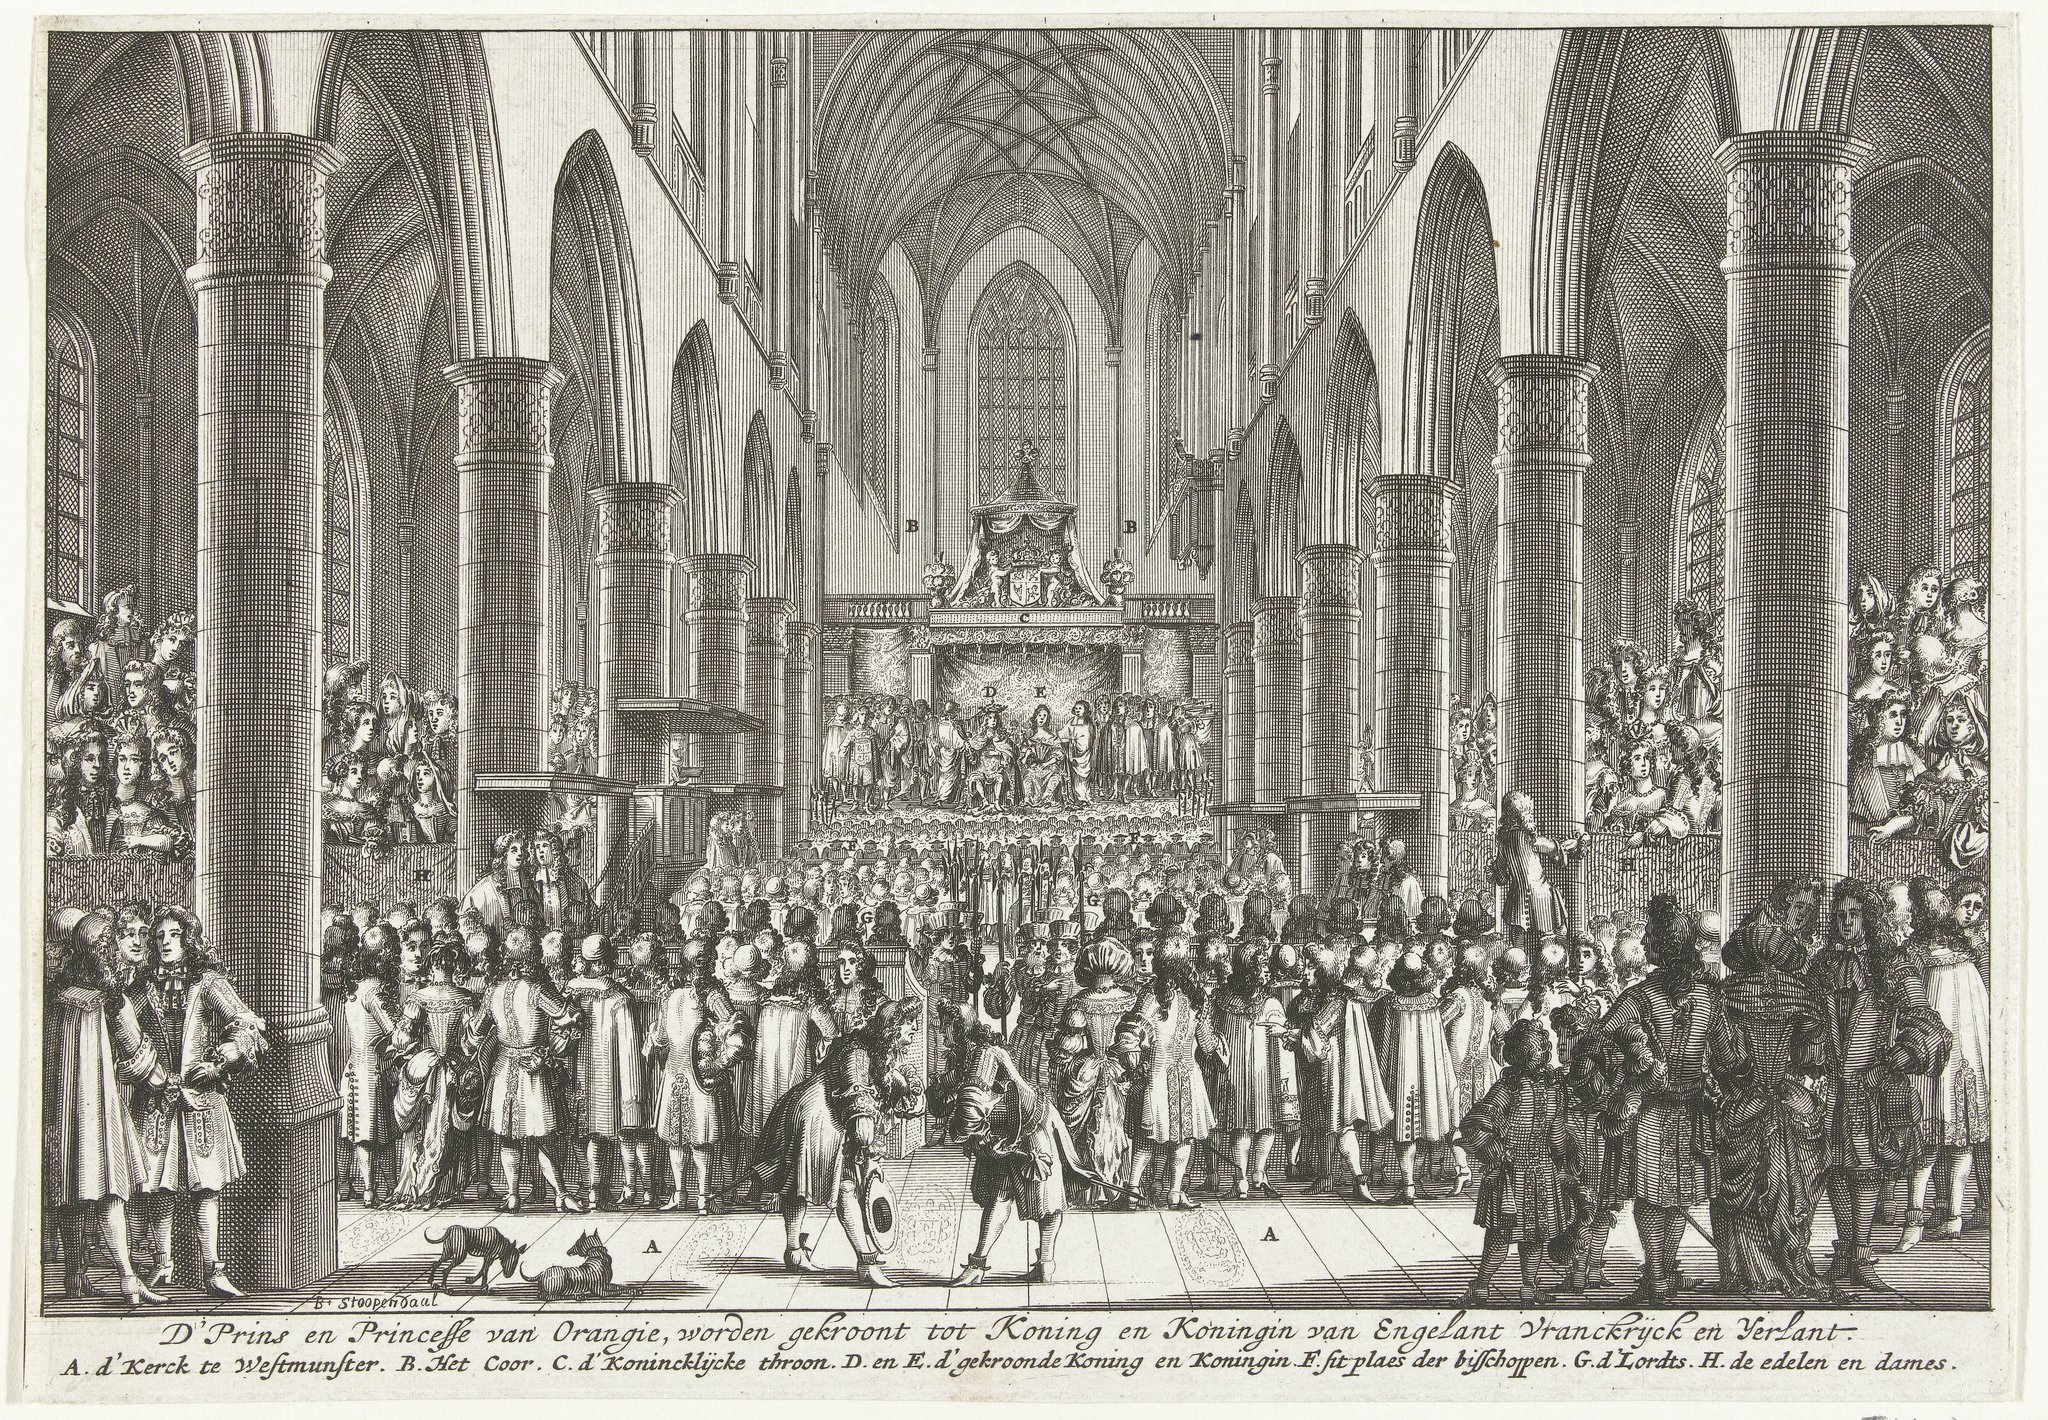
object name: print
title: D' Prins en Princesse van Orangie, worden gekroont tot Koning en Koningin van Engelant, Vranckrijck en Yerlant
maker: bastiaen stopendael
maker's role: print maker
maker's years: 1636-1693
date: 1689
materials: paper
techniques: engraving, etching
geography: northern netherlands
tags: william iii (prince of orange and king of england, scotland, and ireland), london, maria ii stuart (koningin van engeland, schotland en ierland), coronation of a ruler, westminster abbey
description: Gebruikt als illustratie in: Abraham van Poot, Engelands gods-dienst en vryheid hersteld, door syn hoogheid den heere prince van Oranjen, Marcus Willemsz Doornick, Amsterdam, 1689.